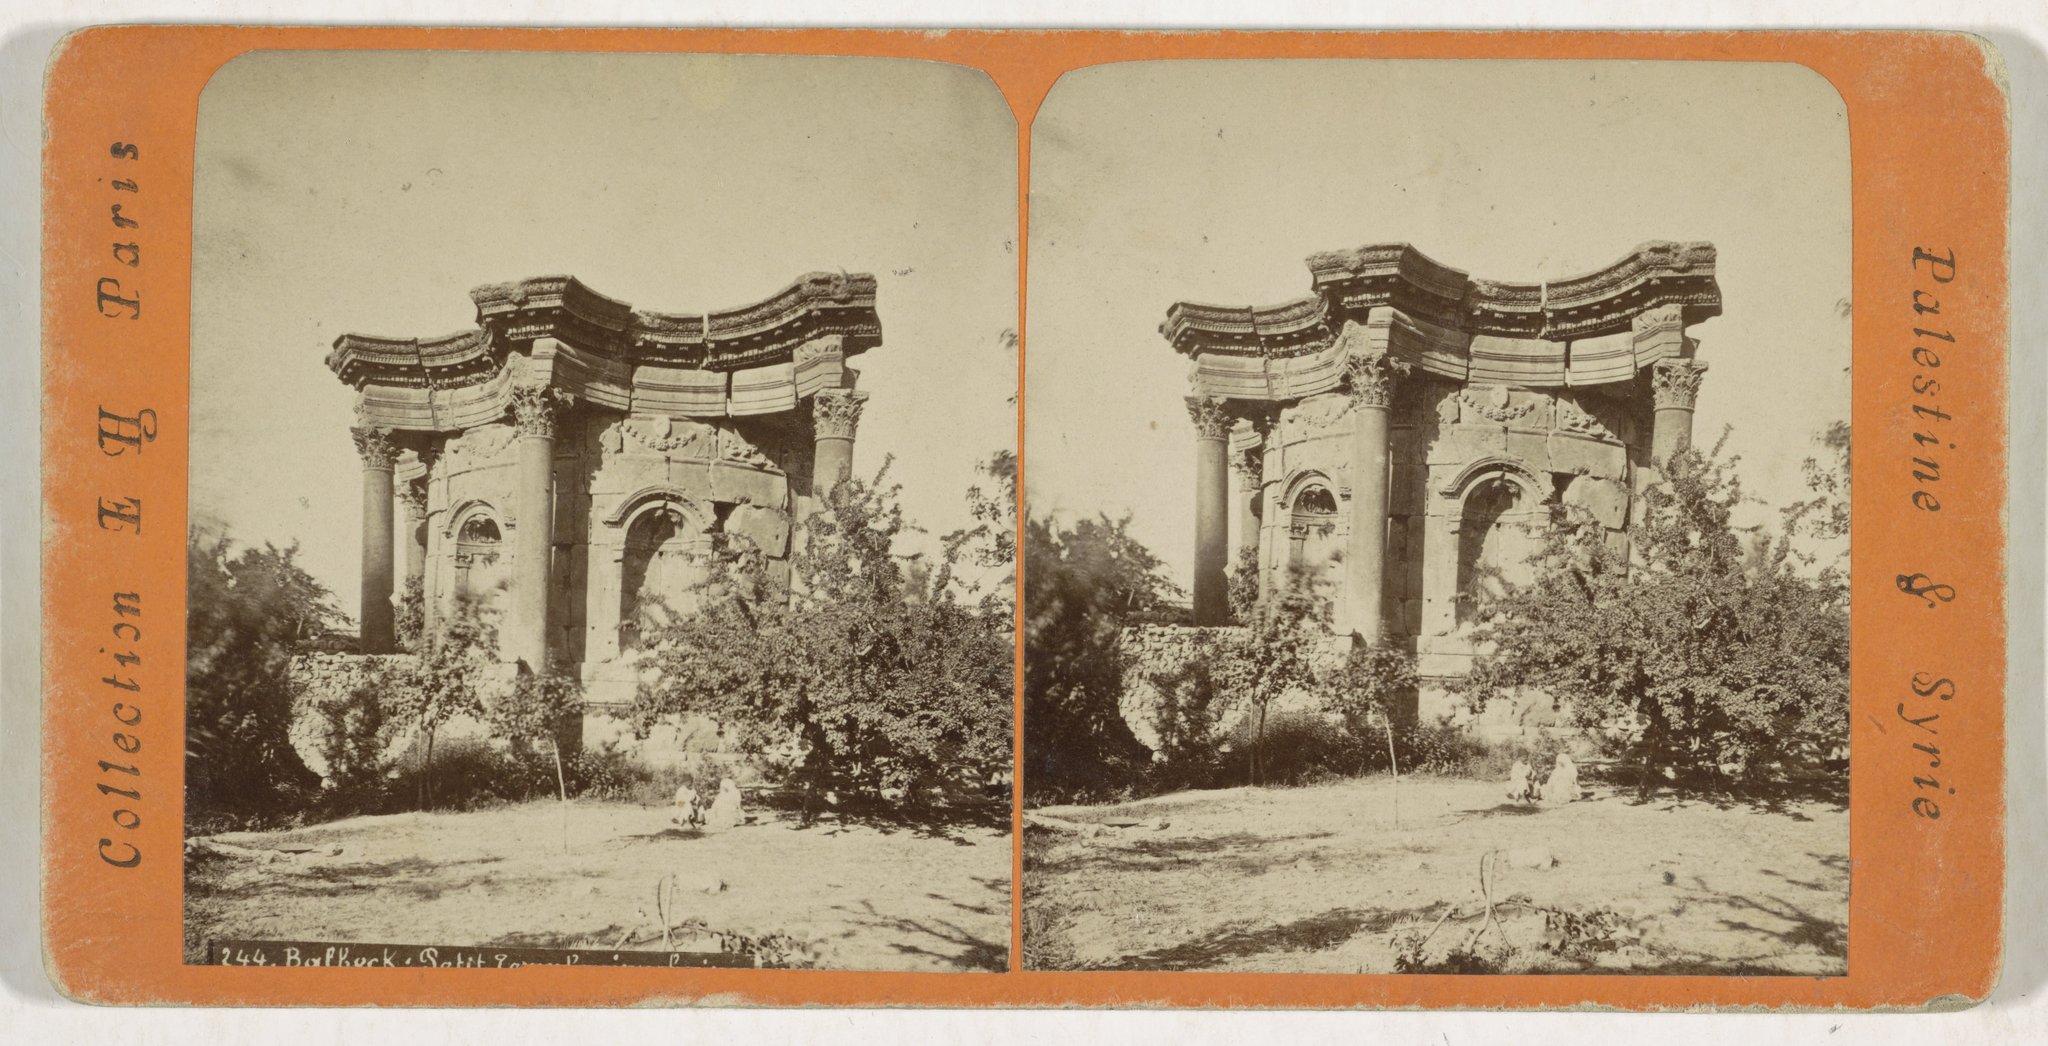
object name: stereograph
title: Palestine & Syrie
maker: eugène hanau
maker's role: publisher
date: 1880-1890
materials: cardboard, paper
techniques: albumen print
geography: baalbek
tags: temple, shrine ~ roman religion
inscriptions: number: ‘244.’, title: ‘Balbeck Petit [...]’